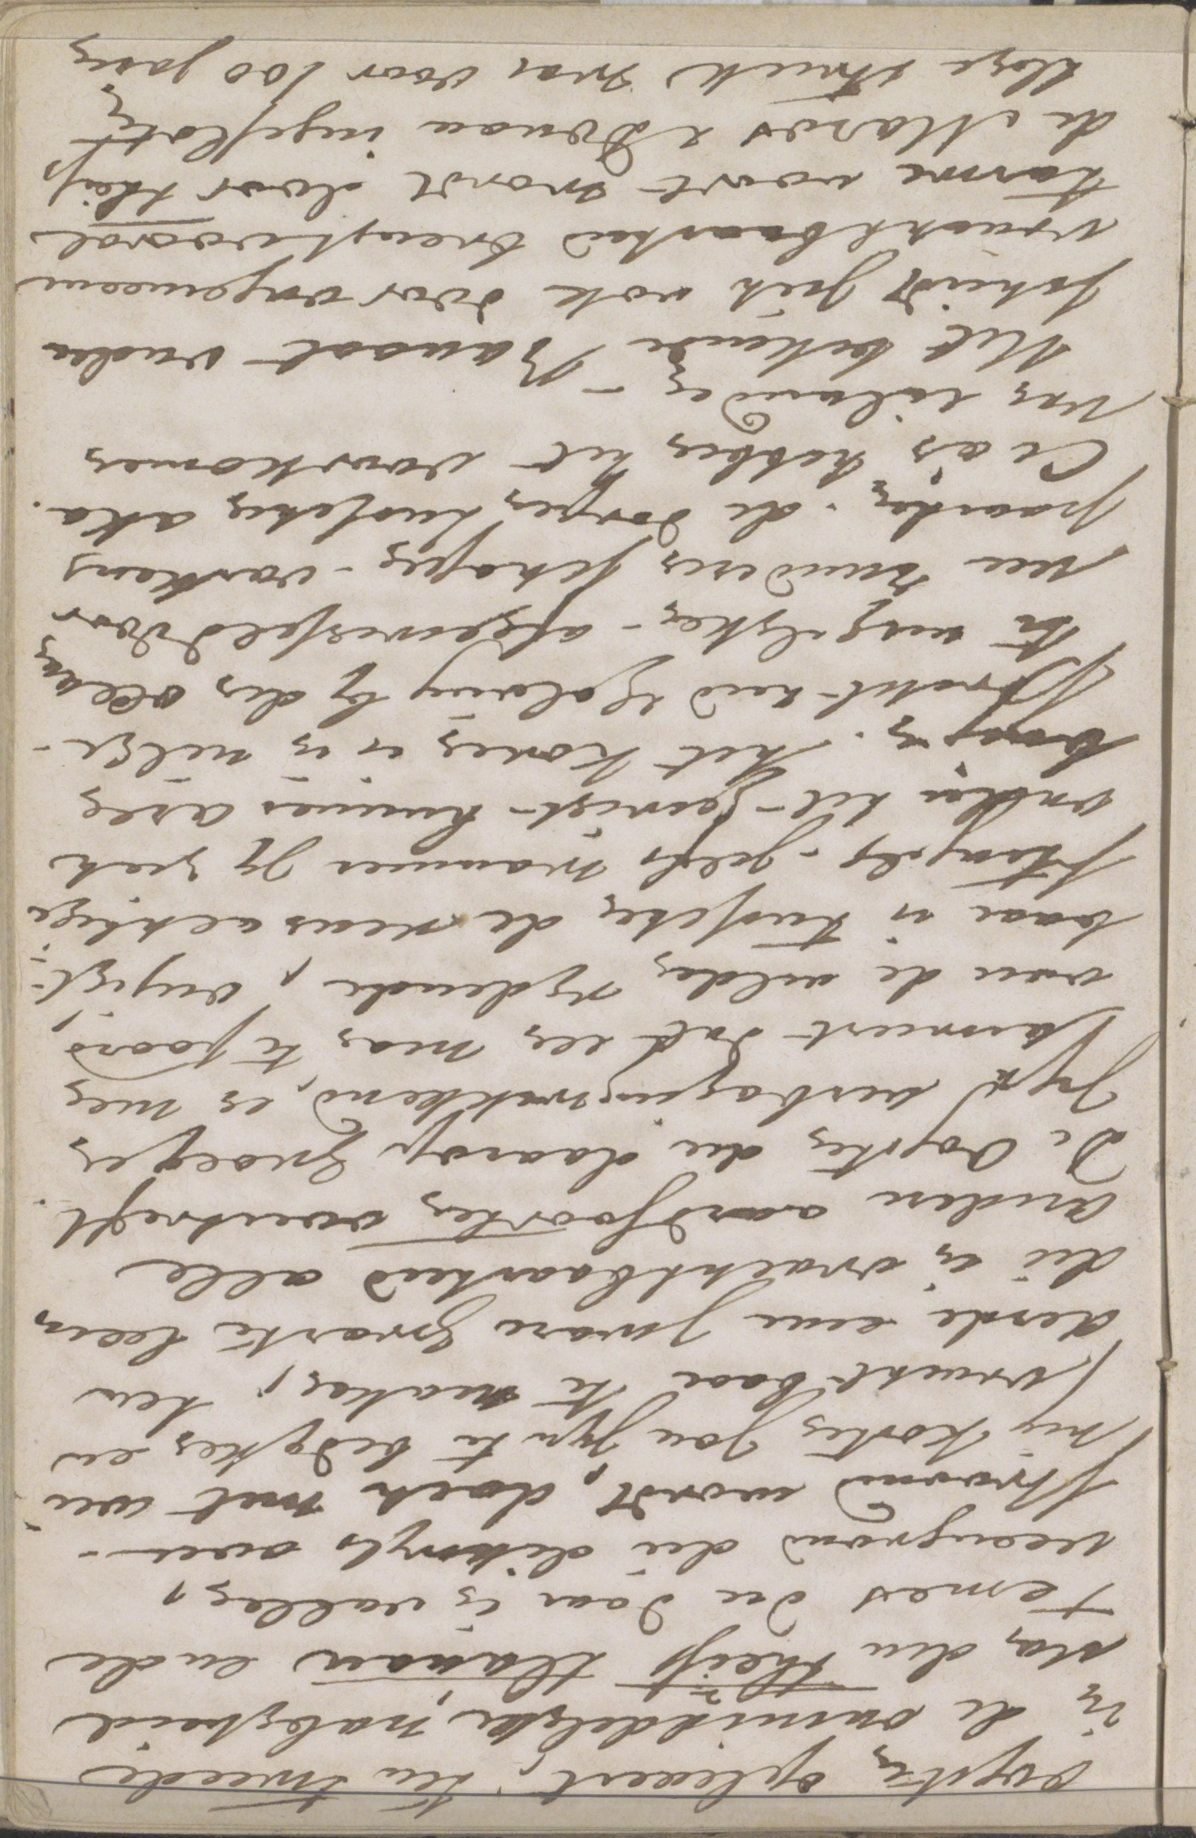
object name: sketchbook leaf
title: Deel van een artikel over Hongarije gekopieerd uit de 'Quarterly Review'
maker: johannes tavenraat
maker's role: draughtsman, painter, print maker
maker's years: 1809-1881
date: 1862-1864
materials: ink, paper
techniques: pen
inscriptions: annotation: ‘[...]’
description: Blad 54 verso uit een schetsboek met 65 bladen.